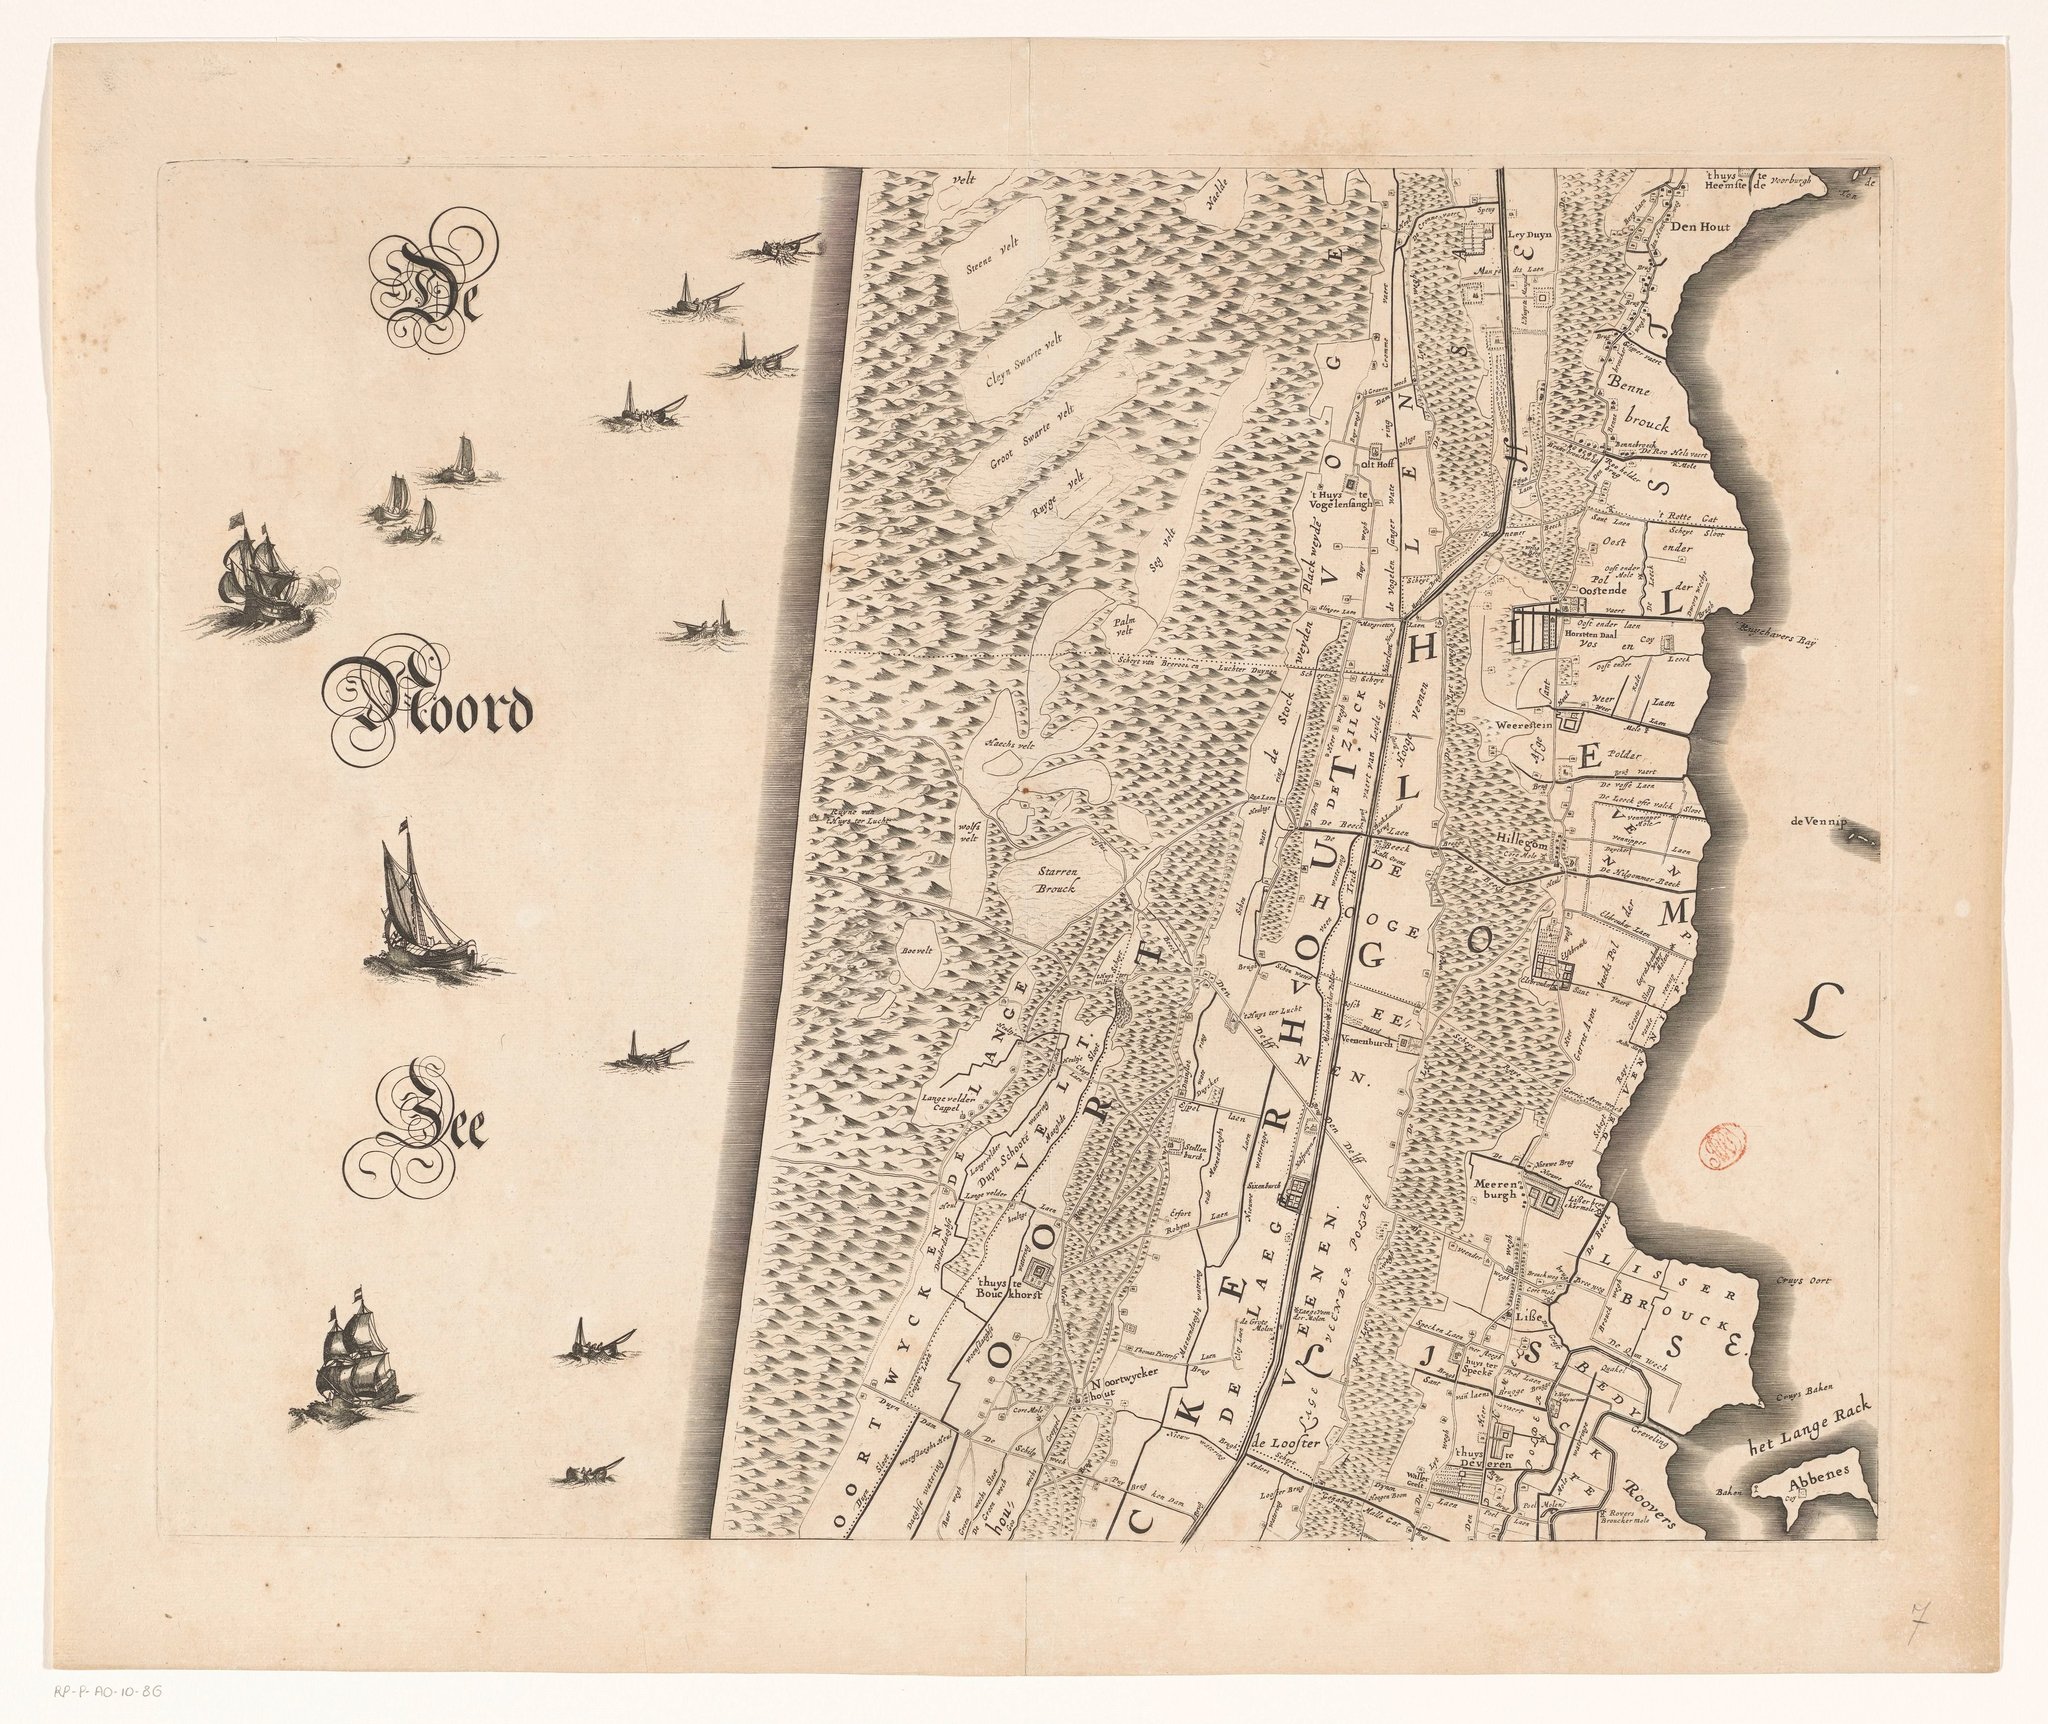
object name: print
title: T' Hoogheymraedschap van Rhynland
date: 1647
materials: paper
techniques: engraving, etching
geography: amsterdam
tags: maps of separate countries or regions, polder, reclaimed land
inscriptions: collector's mark: Lugt 195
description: Deze prent behoort tot de tweede druk (1687) van 'T' Hoogheymraedschap van Rhynland', een wandkaart van het Hoogheemraadschap van Rijnland bestaande uit een kaart van het gebied en een sierrand. Van deze kaart zijn voor zover na te gaan drie verschillende drukken bekend, uit respectievelijk 1647, 1687 en 1746. Het kaartdeel is gedrukt van twaalf platen die voor elke druk zijn aangepast. Het vijfde blad van het kaartdeel (RP-P-AO-10-8H) is in of na 1766 nog een keer bijgewerkt en los uitgegeven. Hierdoor zijn van het vijfde blad vier staten bekend en van de overige bladen drie. Zie documentatie voor meer informatie. Bij de eerste en tweede druk hoort een sierrand met daarop de titel, wapenschilden en octrooiverleningen. Delen van de zijkant van de rand van de eerste druk zijn voor de tweede druk herbruikt, terwijl andere delen van de zijkanten en de hele bovenkant nieuw zijn gemaakt door Romeyn de Hooghe. De derde druk heeft slechts een nieuw gemaakte titelstrook langs de bovenkant.